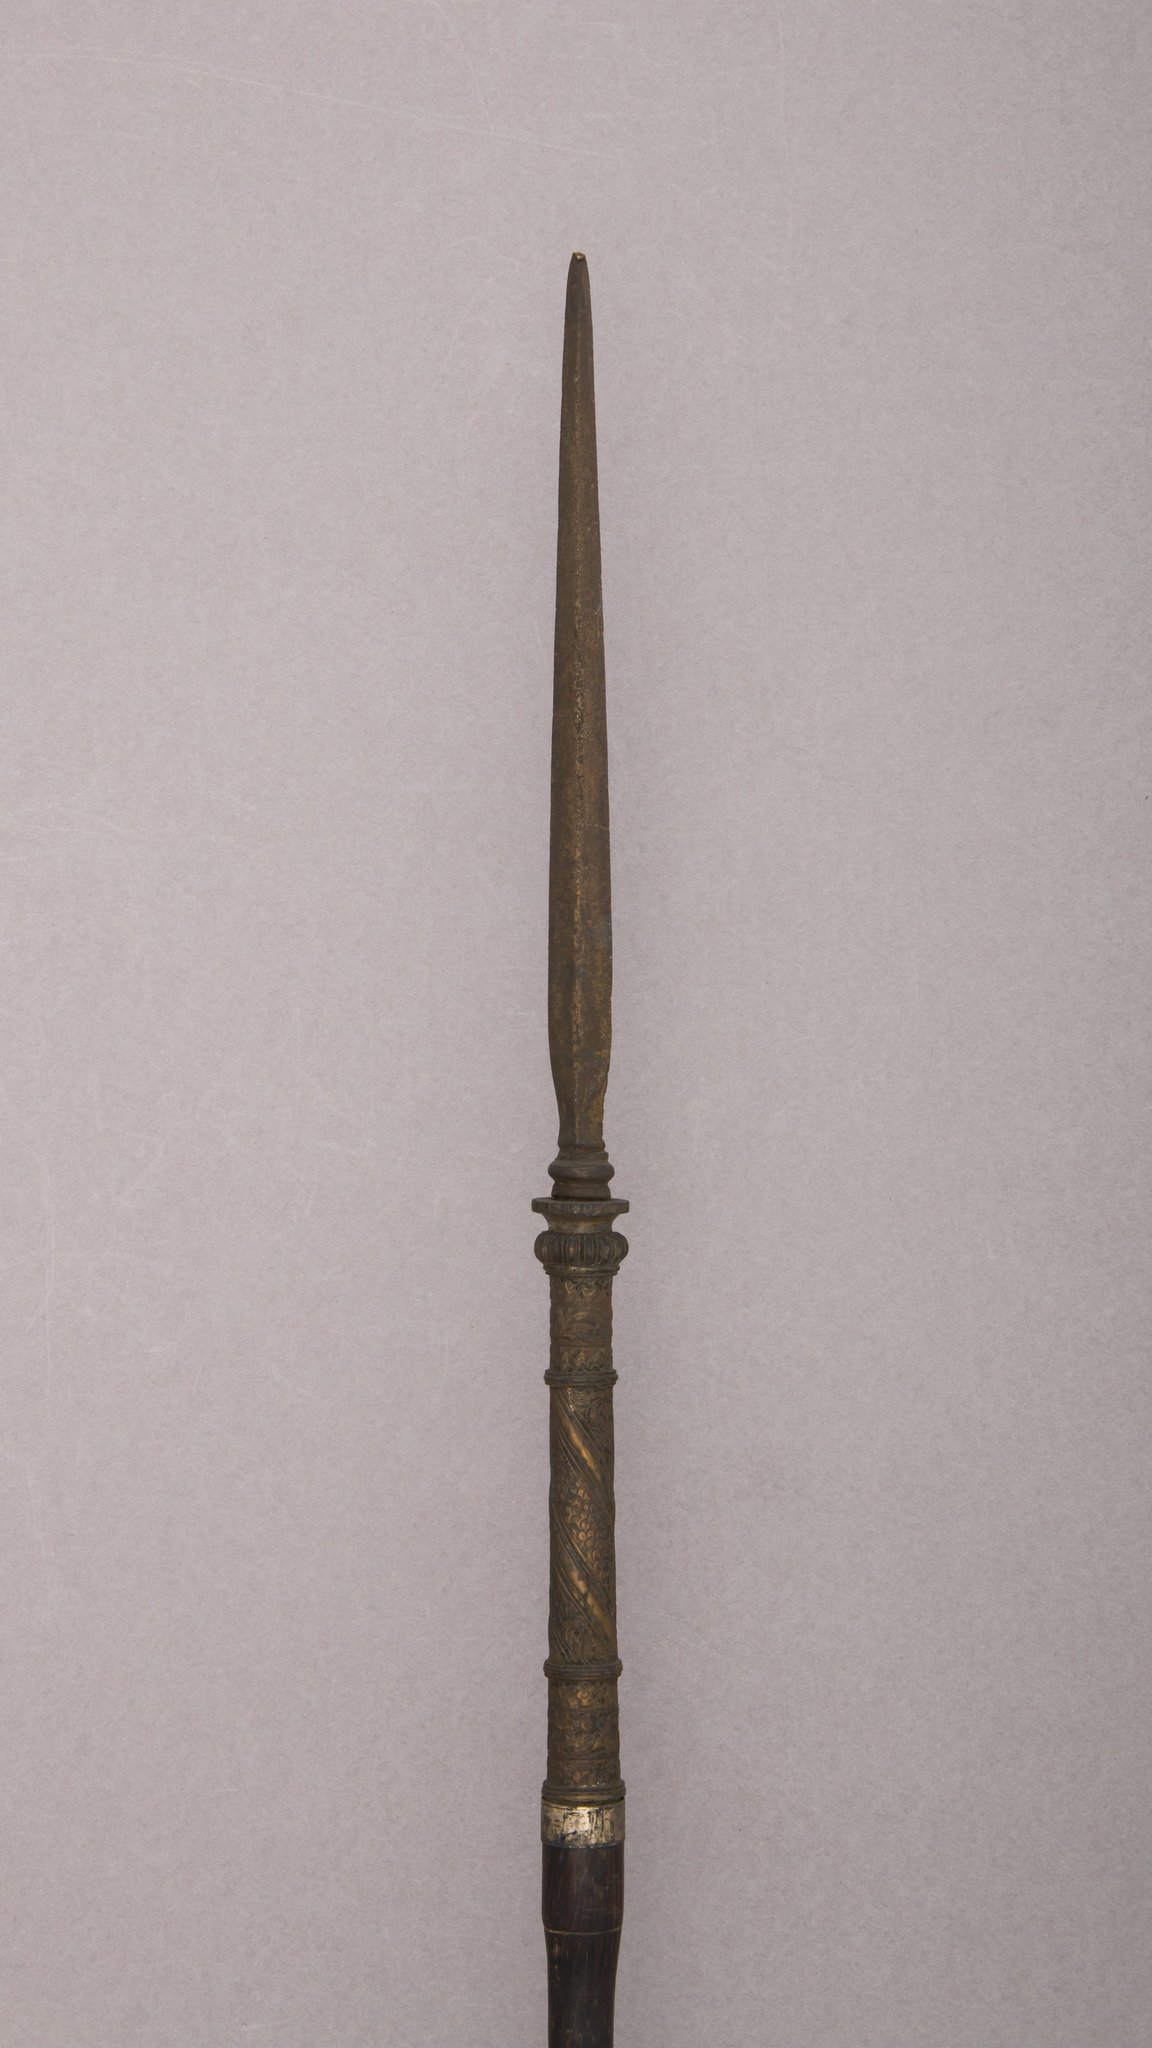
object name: spear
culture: madurese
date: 1701-1900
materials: brass, hair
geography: indonesia